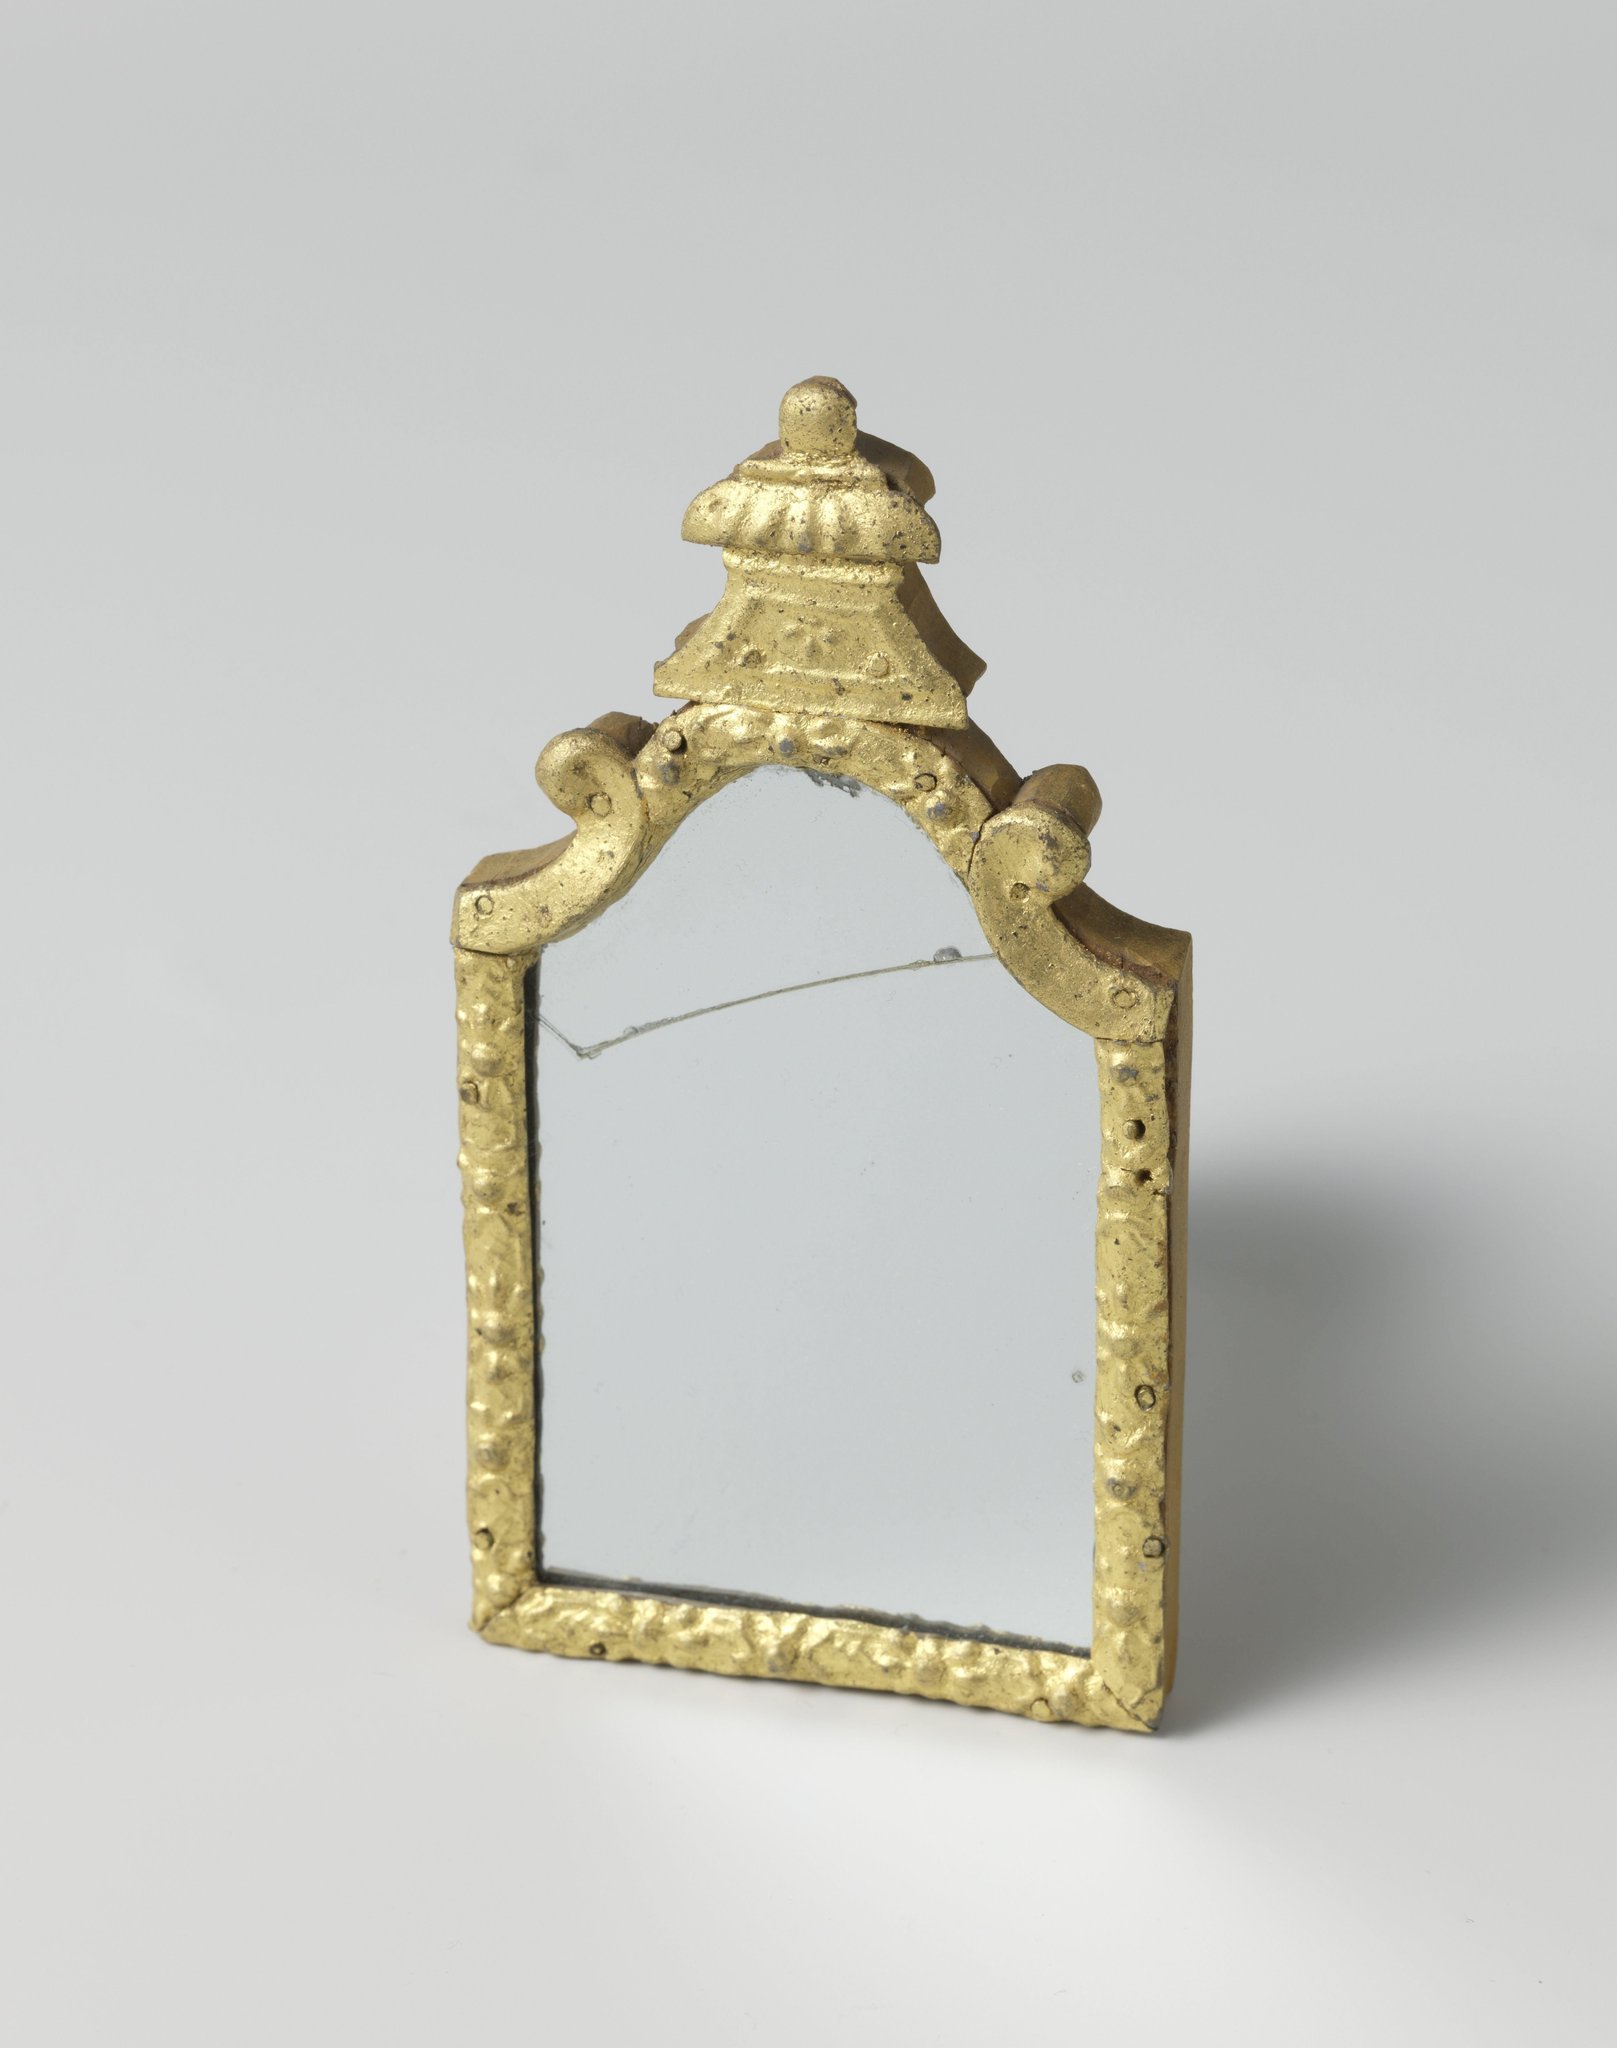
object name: mirror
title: Spiegel in een vergulde lijst met bloemmotieven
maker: Anonymous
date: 1740-1760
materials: amalgam, glass, metal alloy, wood, wool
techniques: gilding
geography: amsterdam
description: Twee spiegels, gevat in een lijst van verguld metaal (tin legering) en gemonteerd op lichtbruin geverfd hout. De gegoten lijst is gedecoreerd met bloemmotieven en een piramidaal opzetstuk met lobben en knop. Tussen het spiegelglas en de houten achterwand bevindt zich een stukje stof.